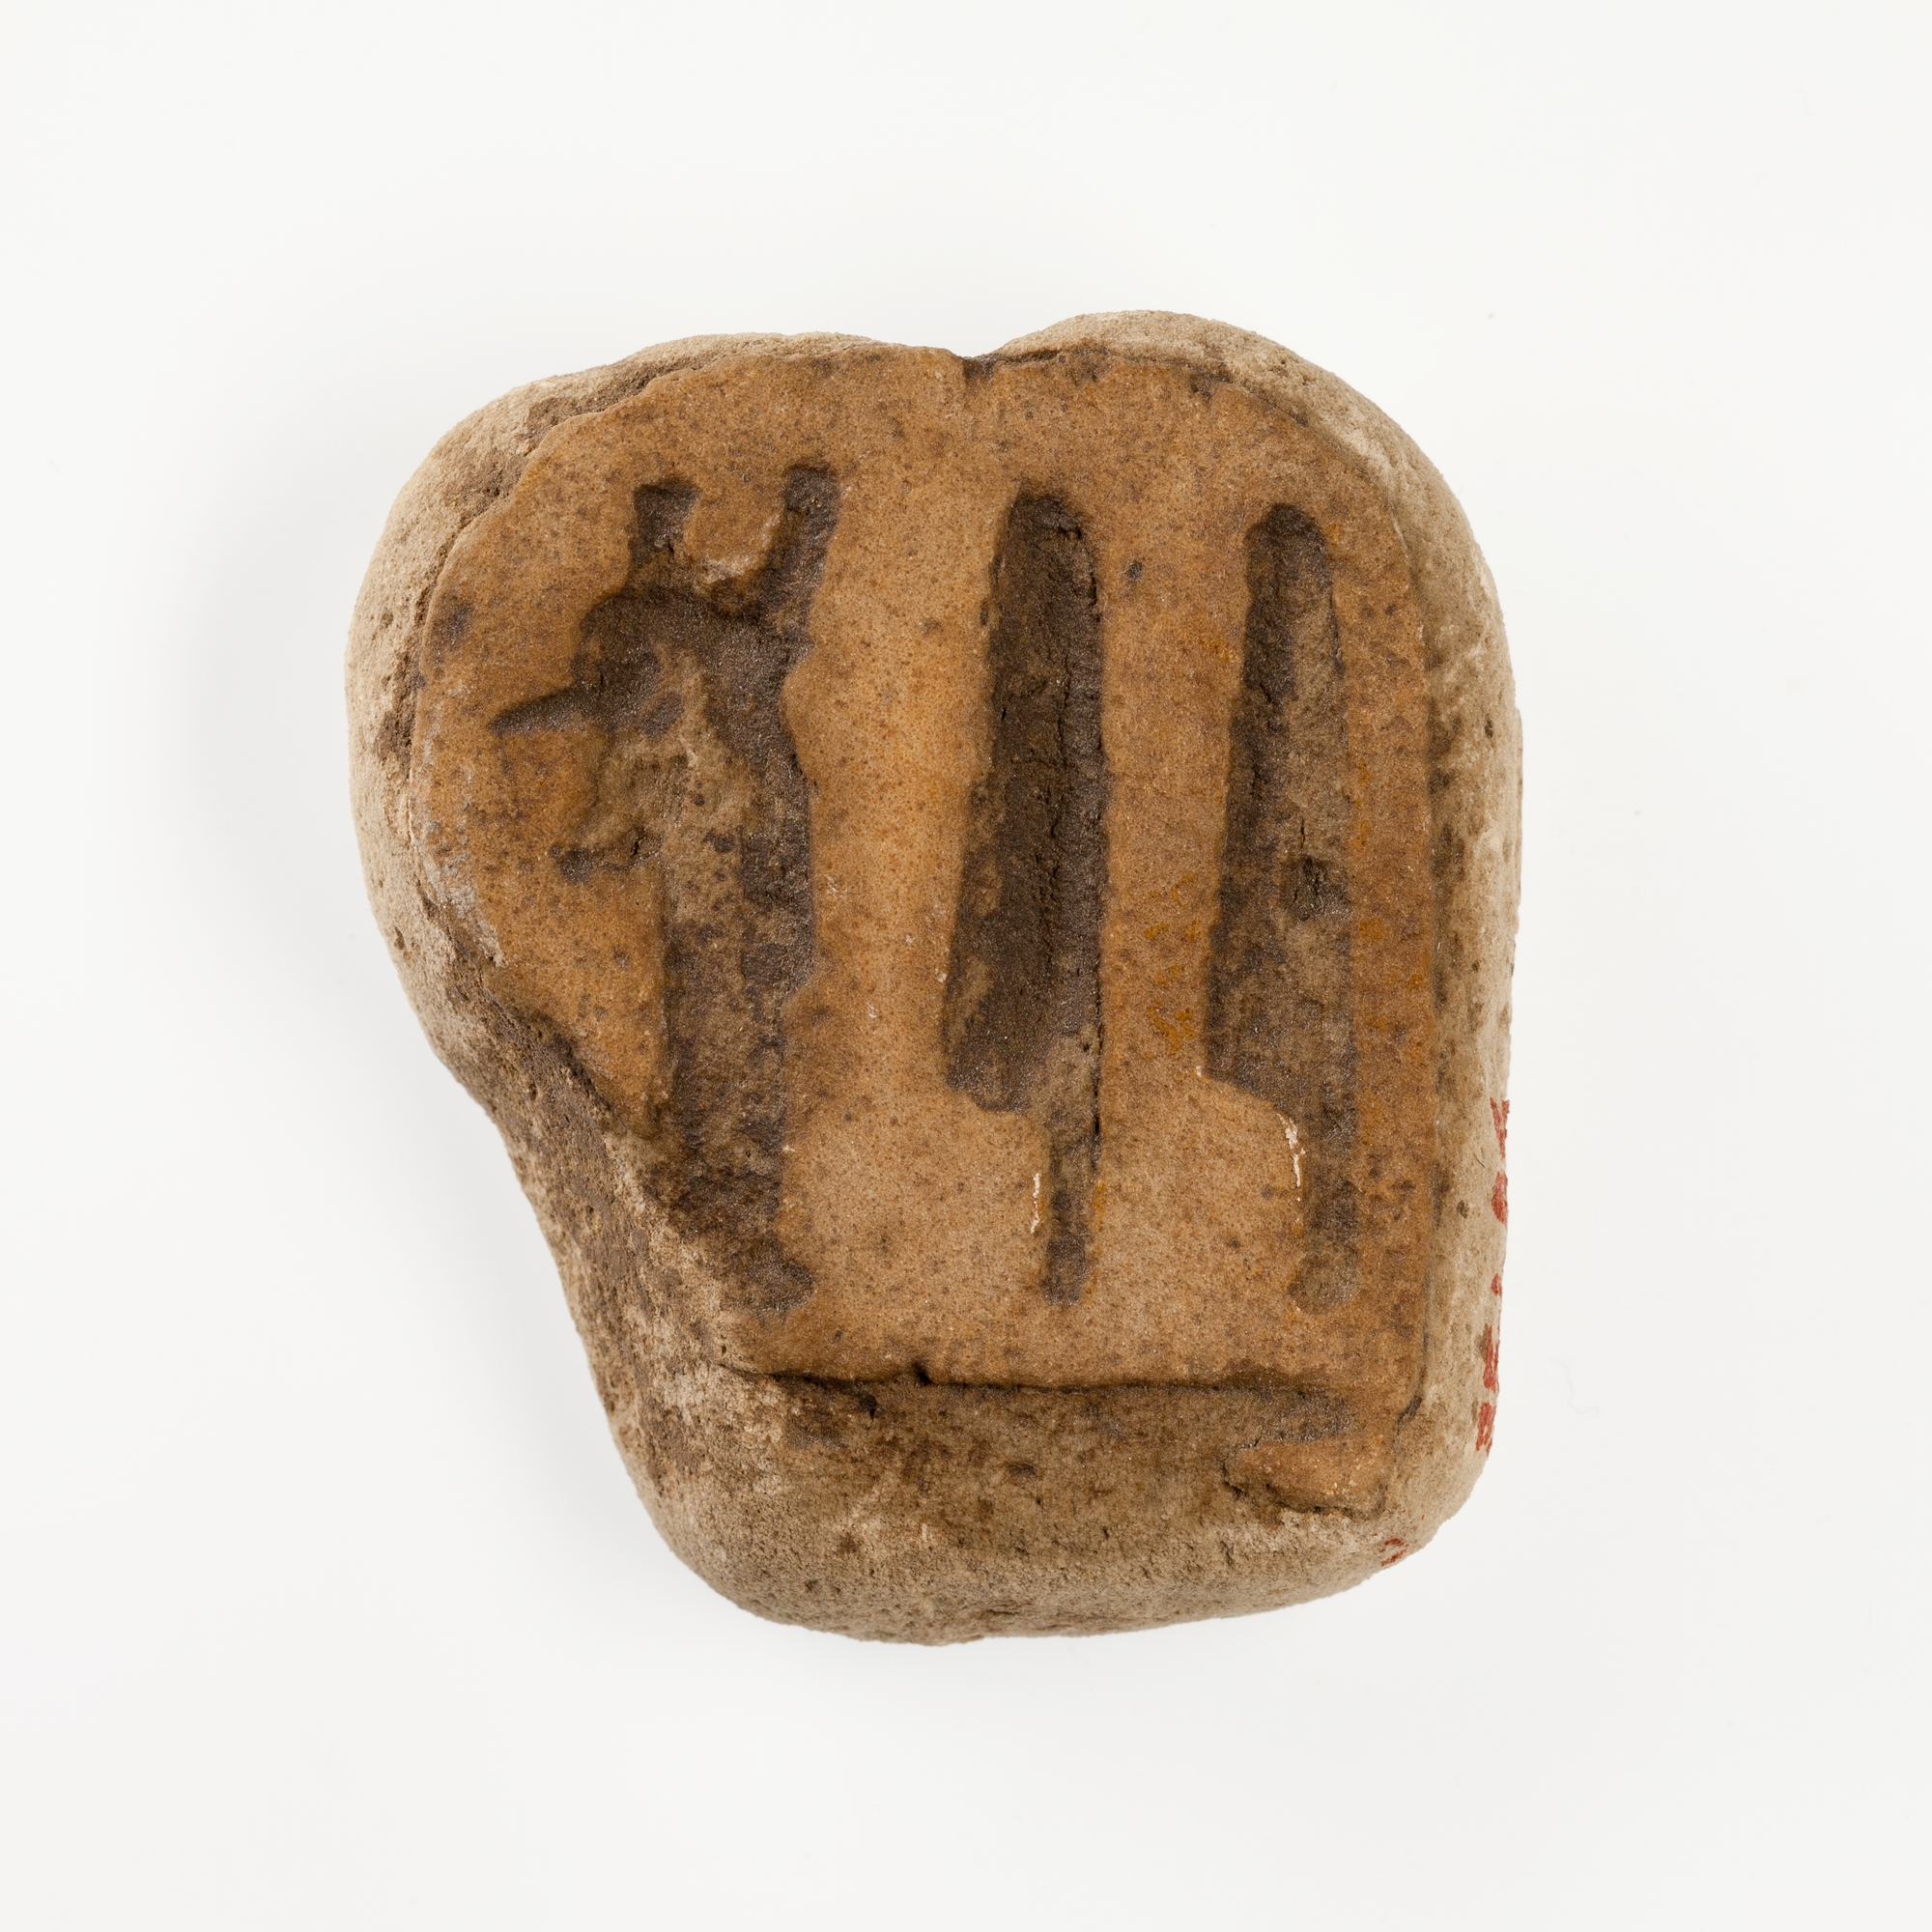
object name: tile, palace of ramesses ii, hieroglyph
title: Tile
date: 1279-1213 BCE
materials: faience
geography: egypt